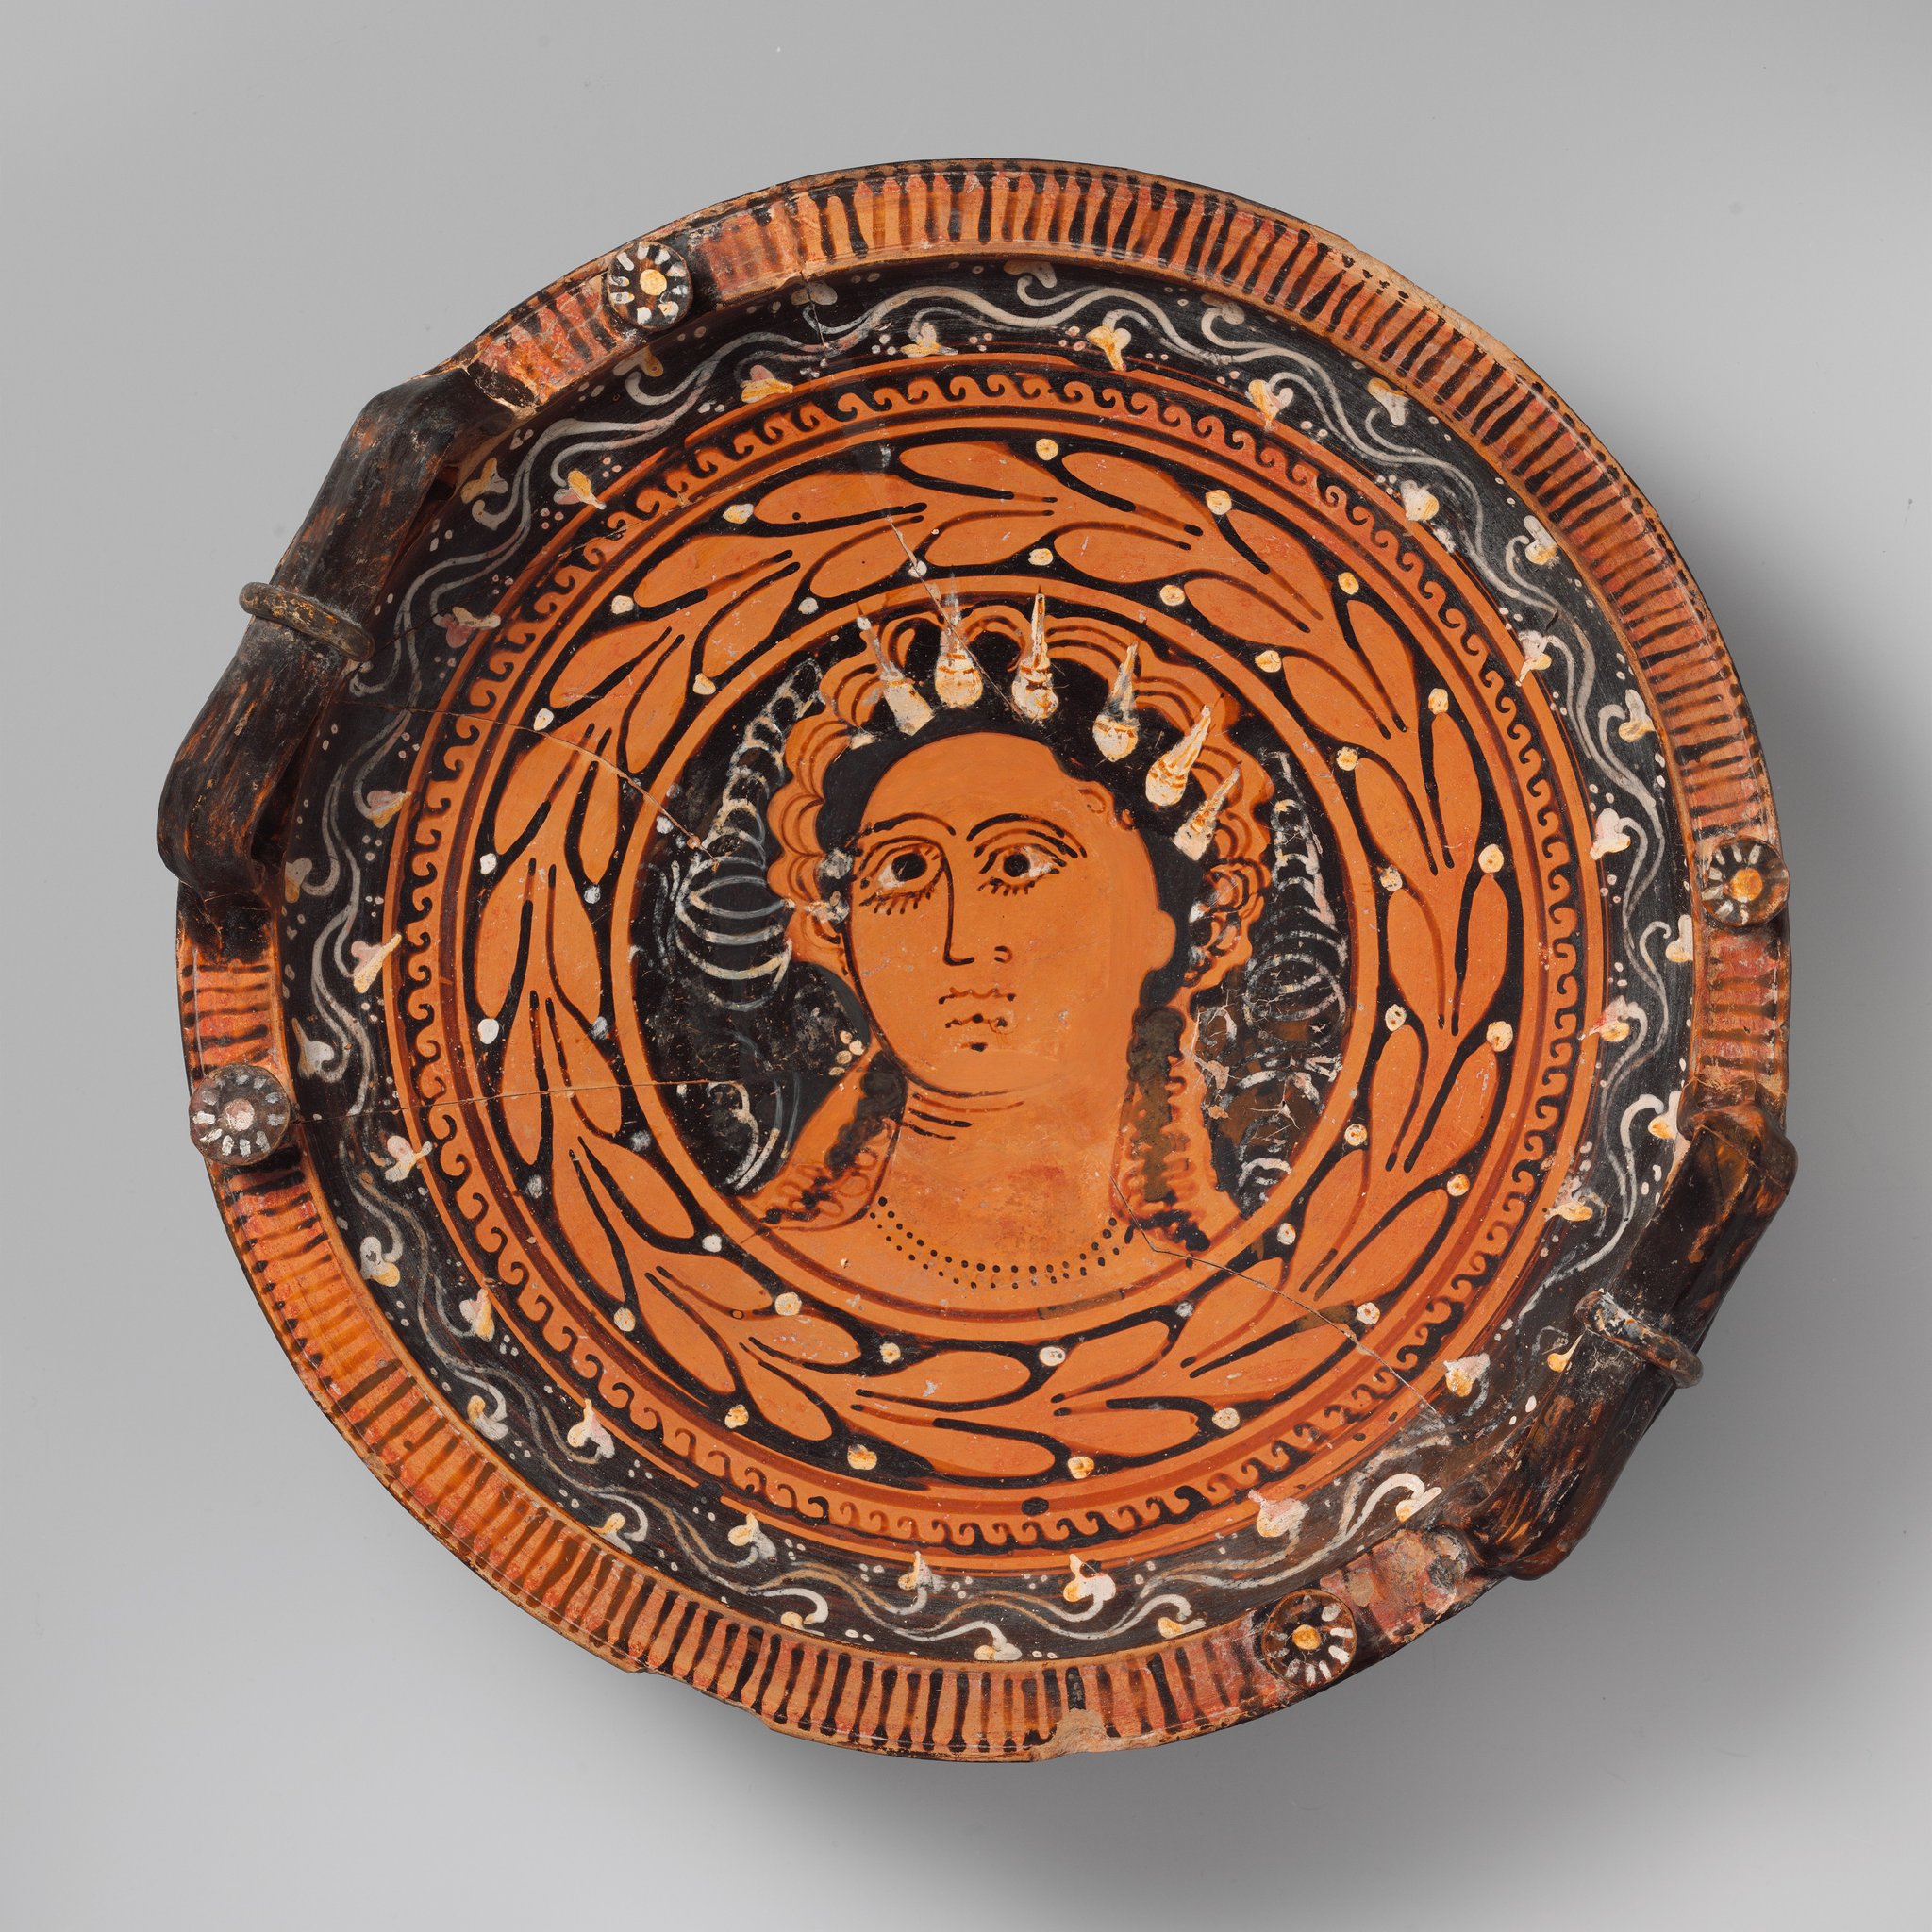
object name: lekane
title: Terracotta lekanis (dish)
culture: greek, south italian, apulian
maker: baltimore painter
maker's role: artist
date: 325-300 BCE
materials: terracotta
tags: heads,women